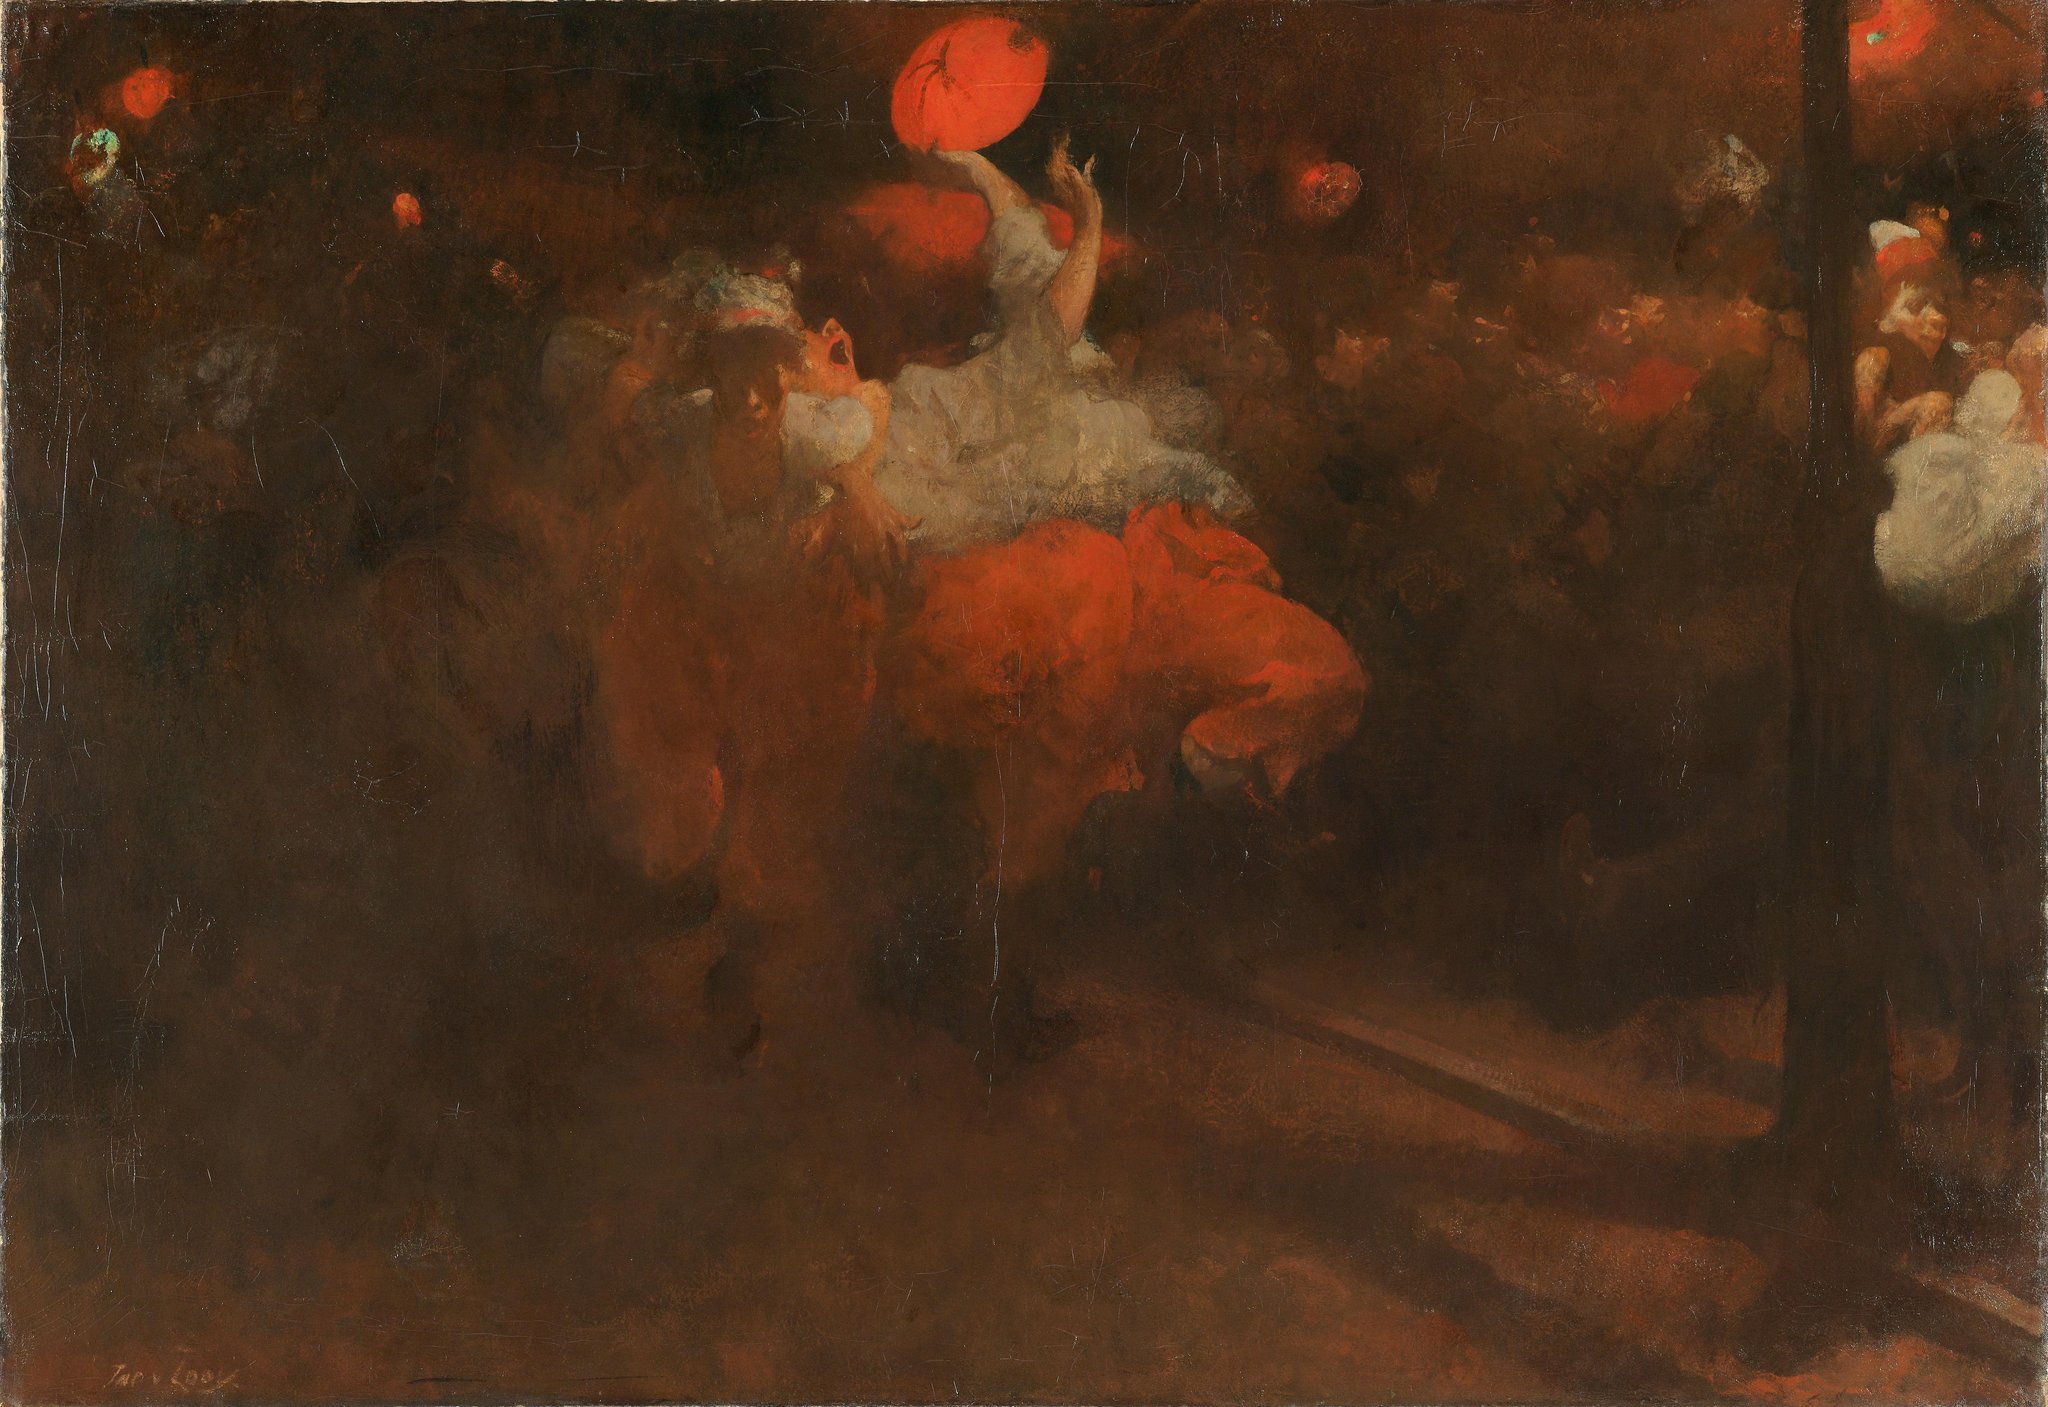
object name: painting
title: Orange Festival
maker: jac van looij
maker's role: draughtsman, painter, print maker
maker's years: 1855-1930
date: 1890-1892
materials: canvas, oil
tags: public festivities on the occasion of royal events, dancing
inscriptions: signature: ‘Jac v. Looy.’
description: Oranjefeest ca. 1890. Dansende gekostuumeerde feestvierders met lampions en vuurwerk op straat, bij nacht.